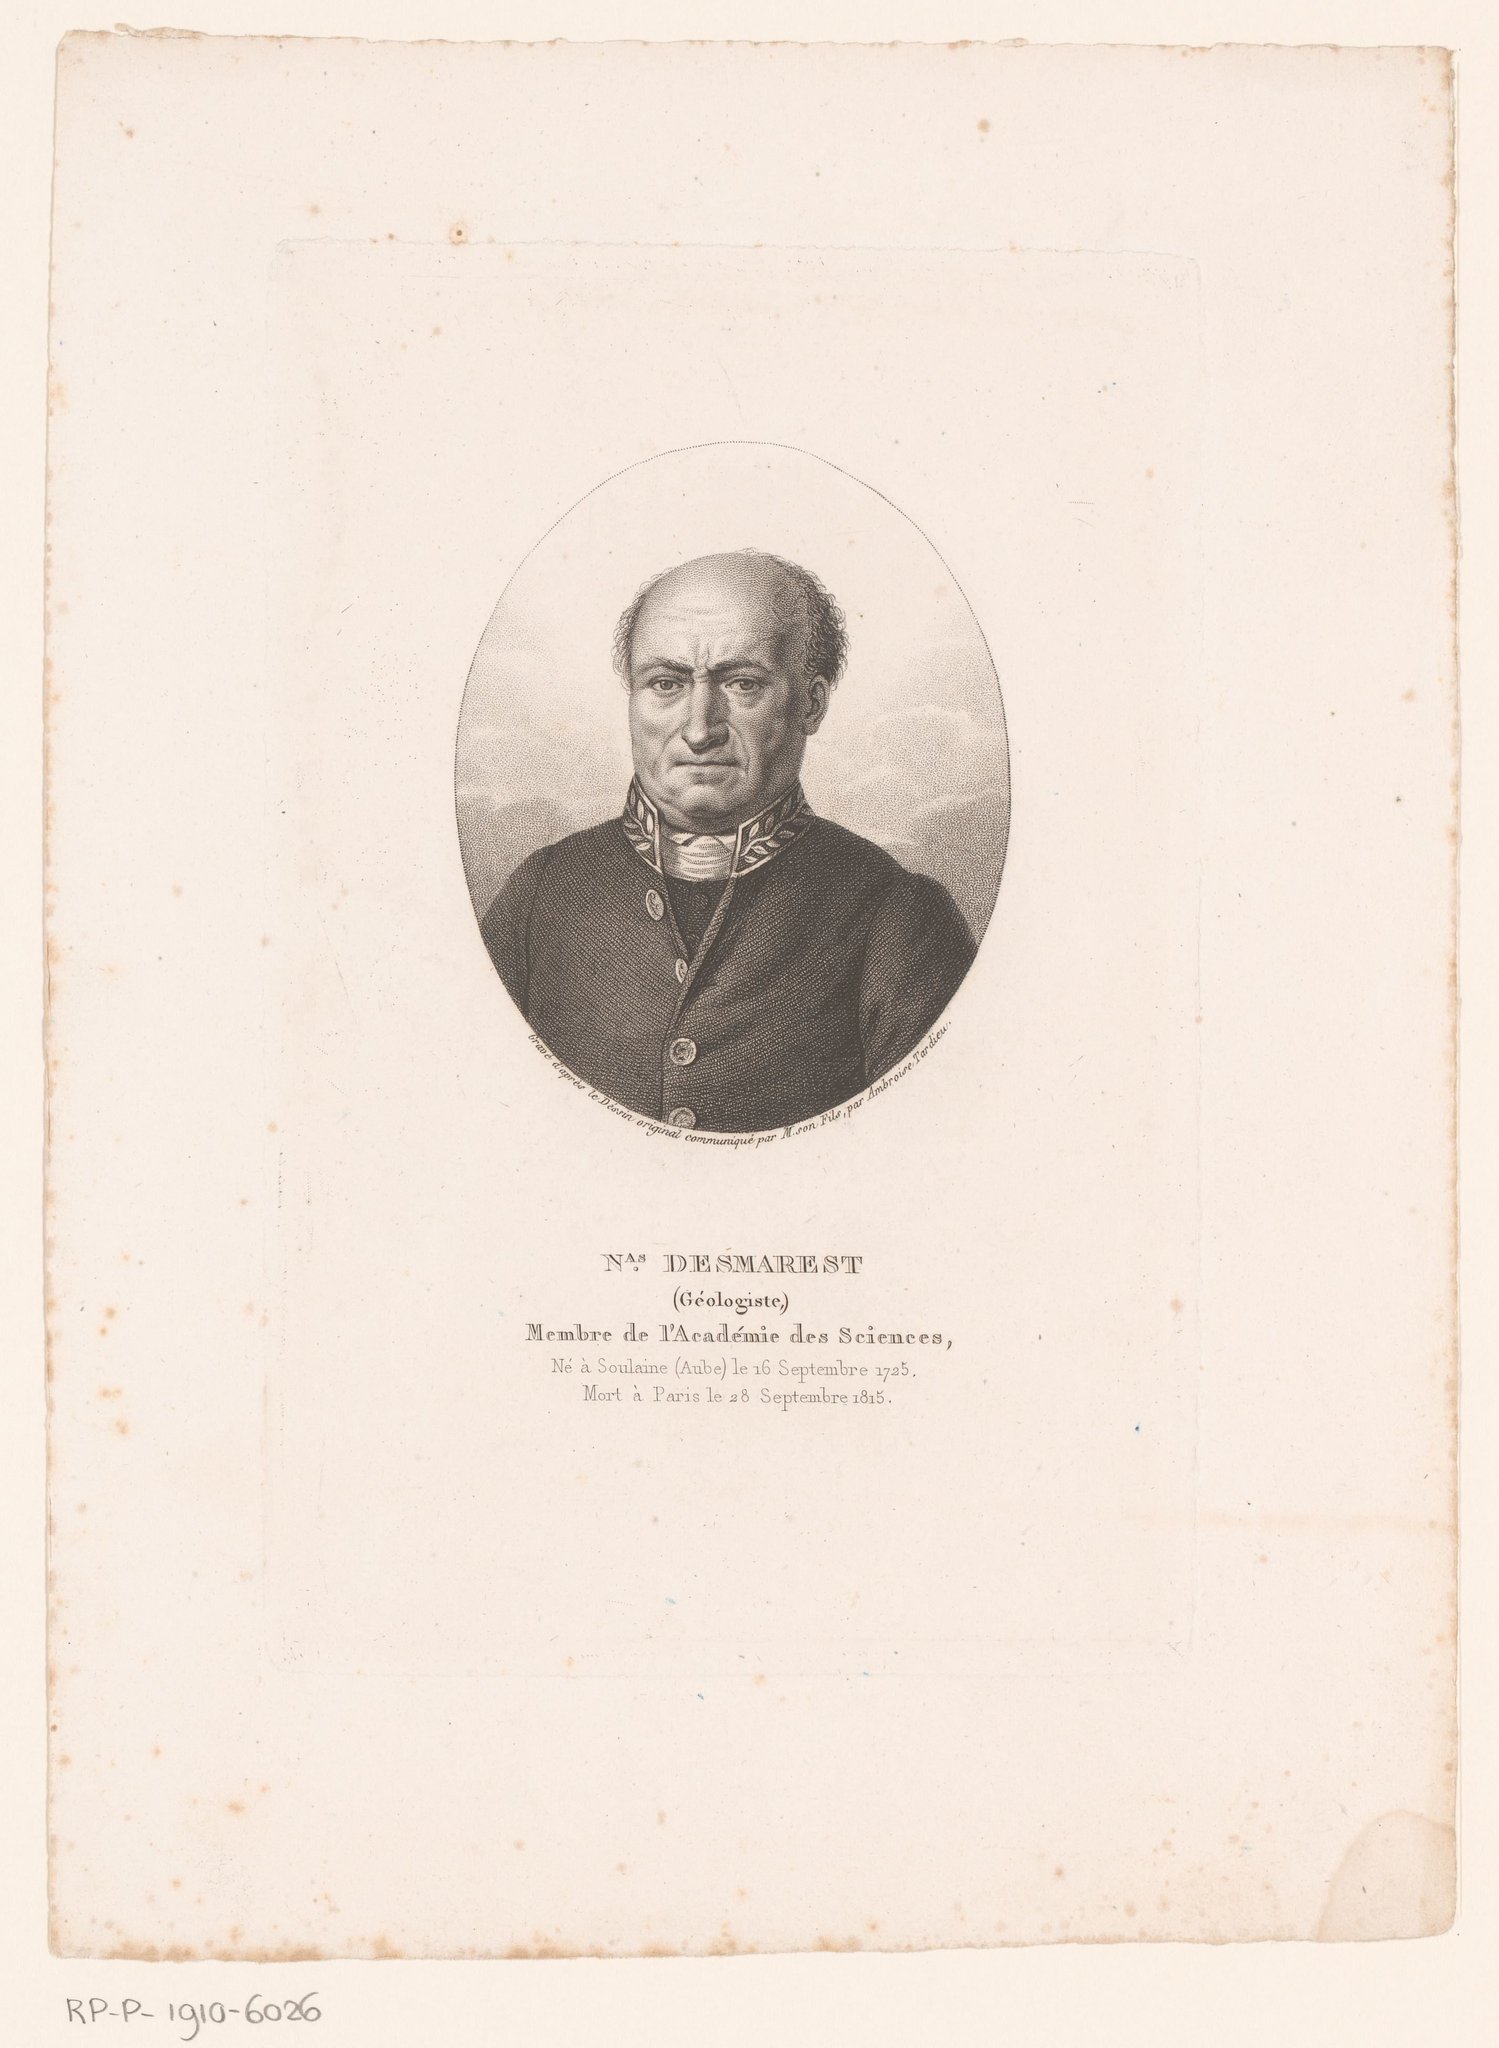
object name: print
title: Collection de tous les personnages célèbres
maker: ambroise tardieu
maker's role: print maker, printer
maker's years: 1788-1841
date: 1820-1828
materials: paper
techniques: engraving, roulette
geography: paris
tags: scholar, philosopher, historical persons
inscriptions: collector's mark: Lugt 2228